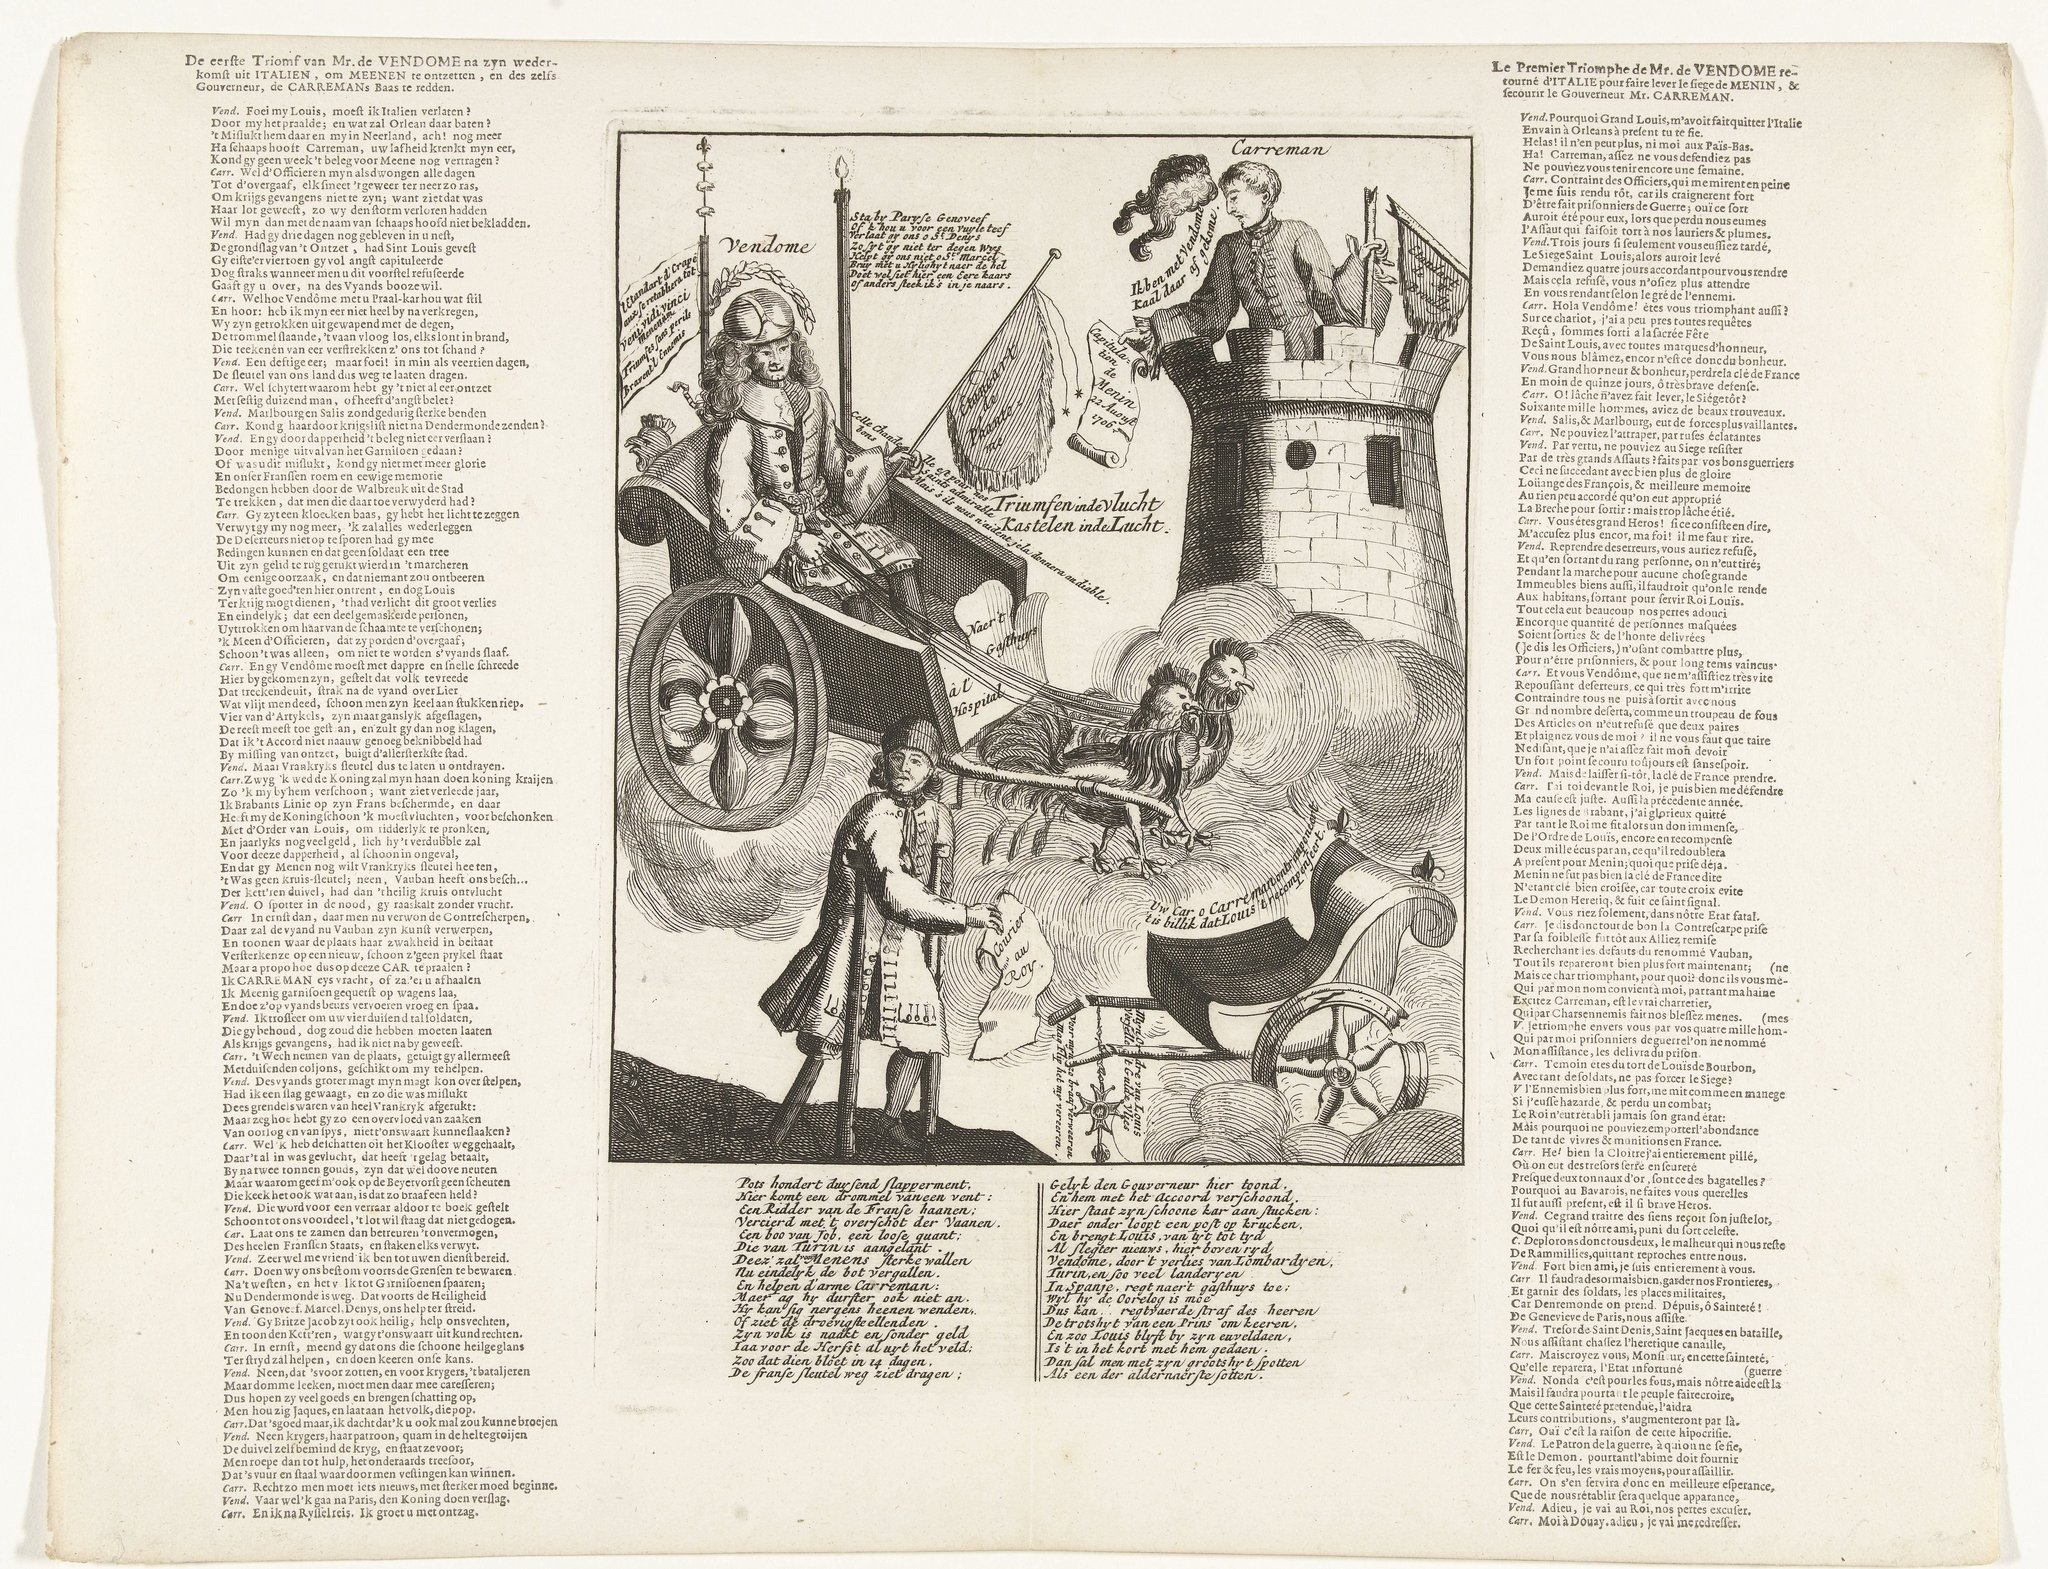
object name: cartoon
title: Triumfen in de vlucht / Kastelen in de Lucht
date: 1706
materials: paper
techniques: engraving, etching, letterpress printing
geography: northern netherlands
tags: paris, political caricatures and satires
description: Spotprent op het verlies van Menen en de komst van de hertog van Vendôme vanuit Italië naar Brabant, 1706. Carremans, de bevelhebber te Menen, staande op een toren beklaagt de overgave van de stad op 22 augustus 1706. Vendôme in een strijdwagen getrokken door Franse hanen. Met verzen in het Nederlands in de plaat en lange verzen in het Nederlands en Frans op het blad gedrukt aan weerszijden van de plaat. Onderdeel van een reeks van 19 spotprenten op de Fransen en bondgenoten uit het jaar 1706.